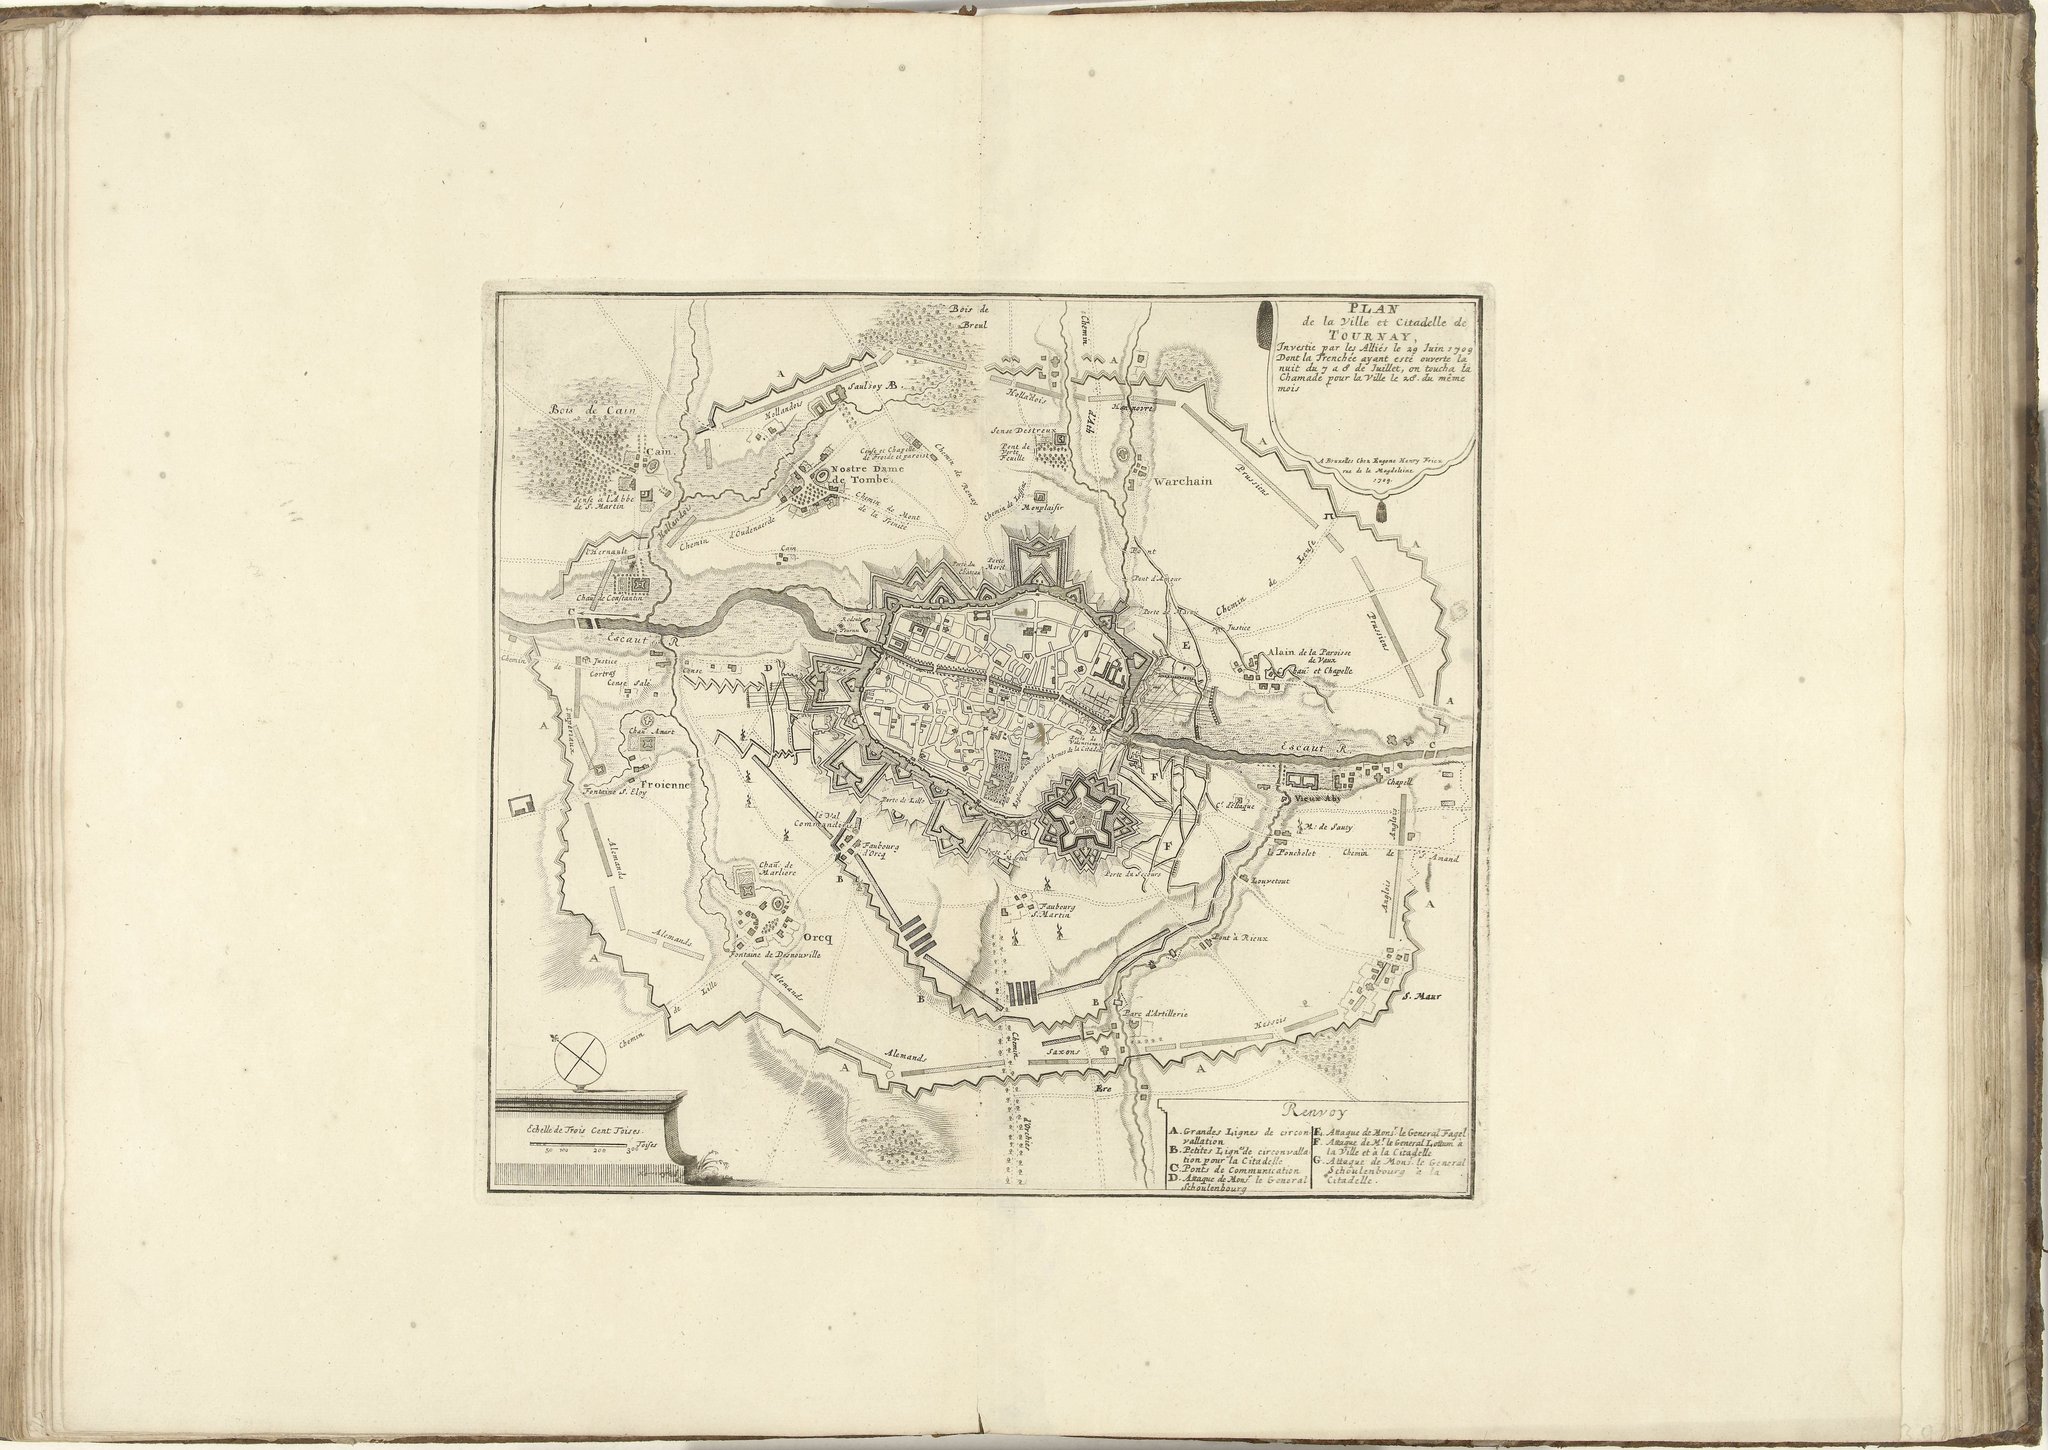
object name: print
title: Plan de la Ville et Citadelle de Tournay, Investie par les Alliés le 29 Juin 1709 Dont la Trenchée ayant esté ouvete la nuit du 7 a 8 de Juillet, on tocha la Chamade pour la Ville le 28. du même mois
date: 1709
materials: paper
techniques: engraving, etching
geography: brussels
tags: siege, position war, maps of cities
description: Kaart van het beleg van Tournai. De stad belegerd door de Geallieerden vanaf 29 juni en ingenomen op 2 september 1709. Onderdeel van een gebundelde verzameling van plannen van veldslagen en steden vermaard in de Spaanse Successieoorlog.